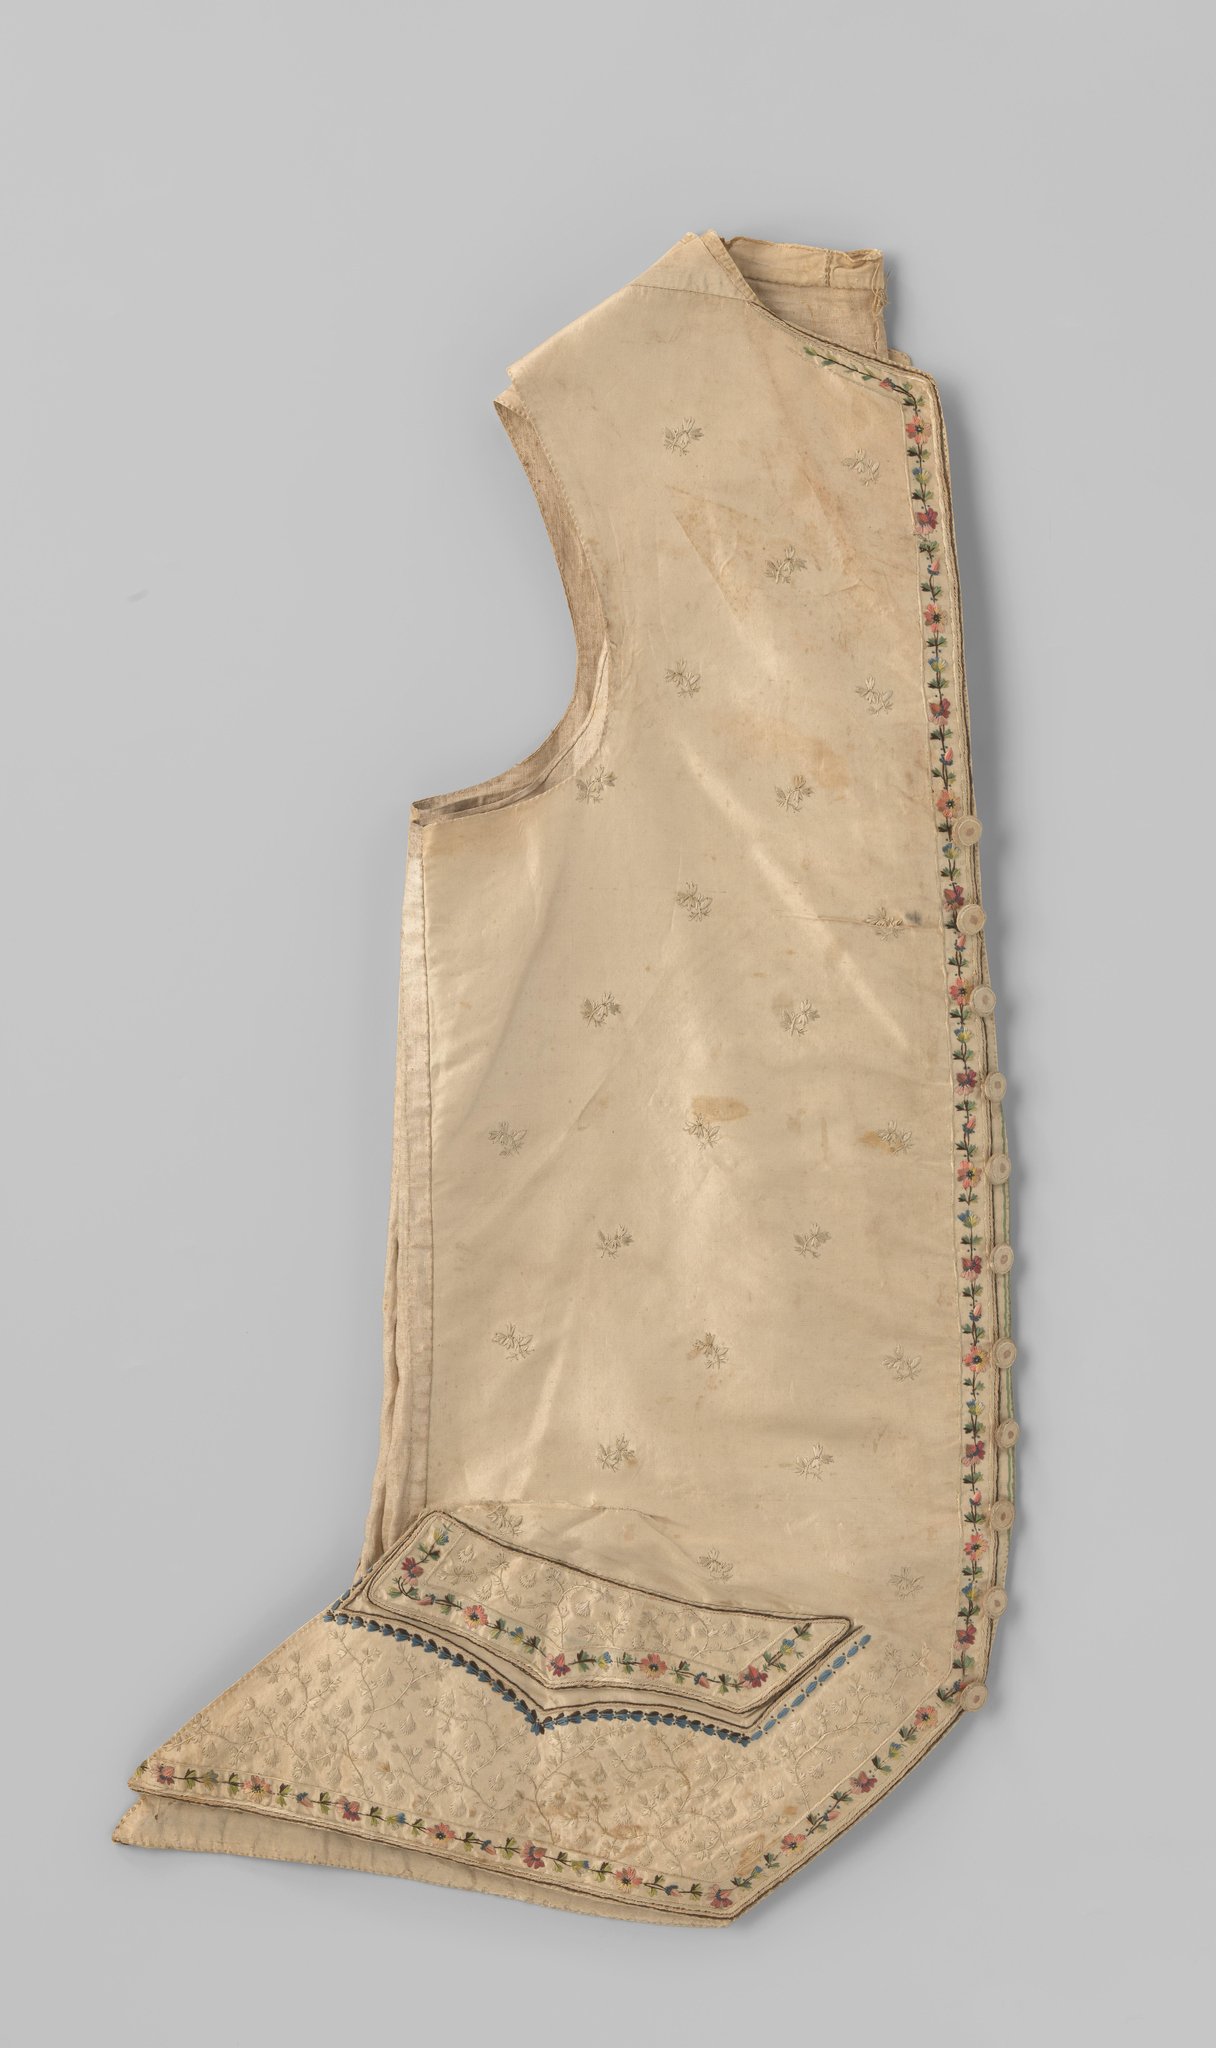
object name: camisole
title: Lang mouwloos vest van crème ripszijde, geborduurd met crème takjes, meerkleurige ranke bloemslingers en blauwzwarte en crèmekleurige bladranken; voering en rug van linnen.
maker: Anonymous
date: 1770-1780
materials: linen, silk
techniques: embroidered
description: Vest van witte zijde, geborduurd met gekleurde bloemen. Strooipatroon van witte takjes, op zakklep en langs onderzijde rand van ranken. Geen kraag, gesloten rug.